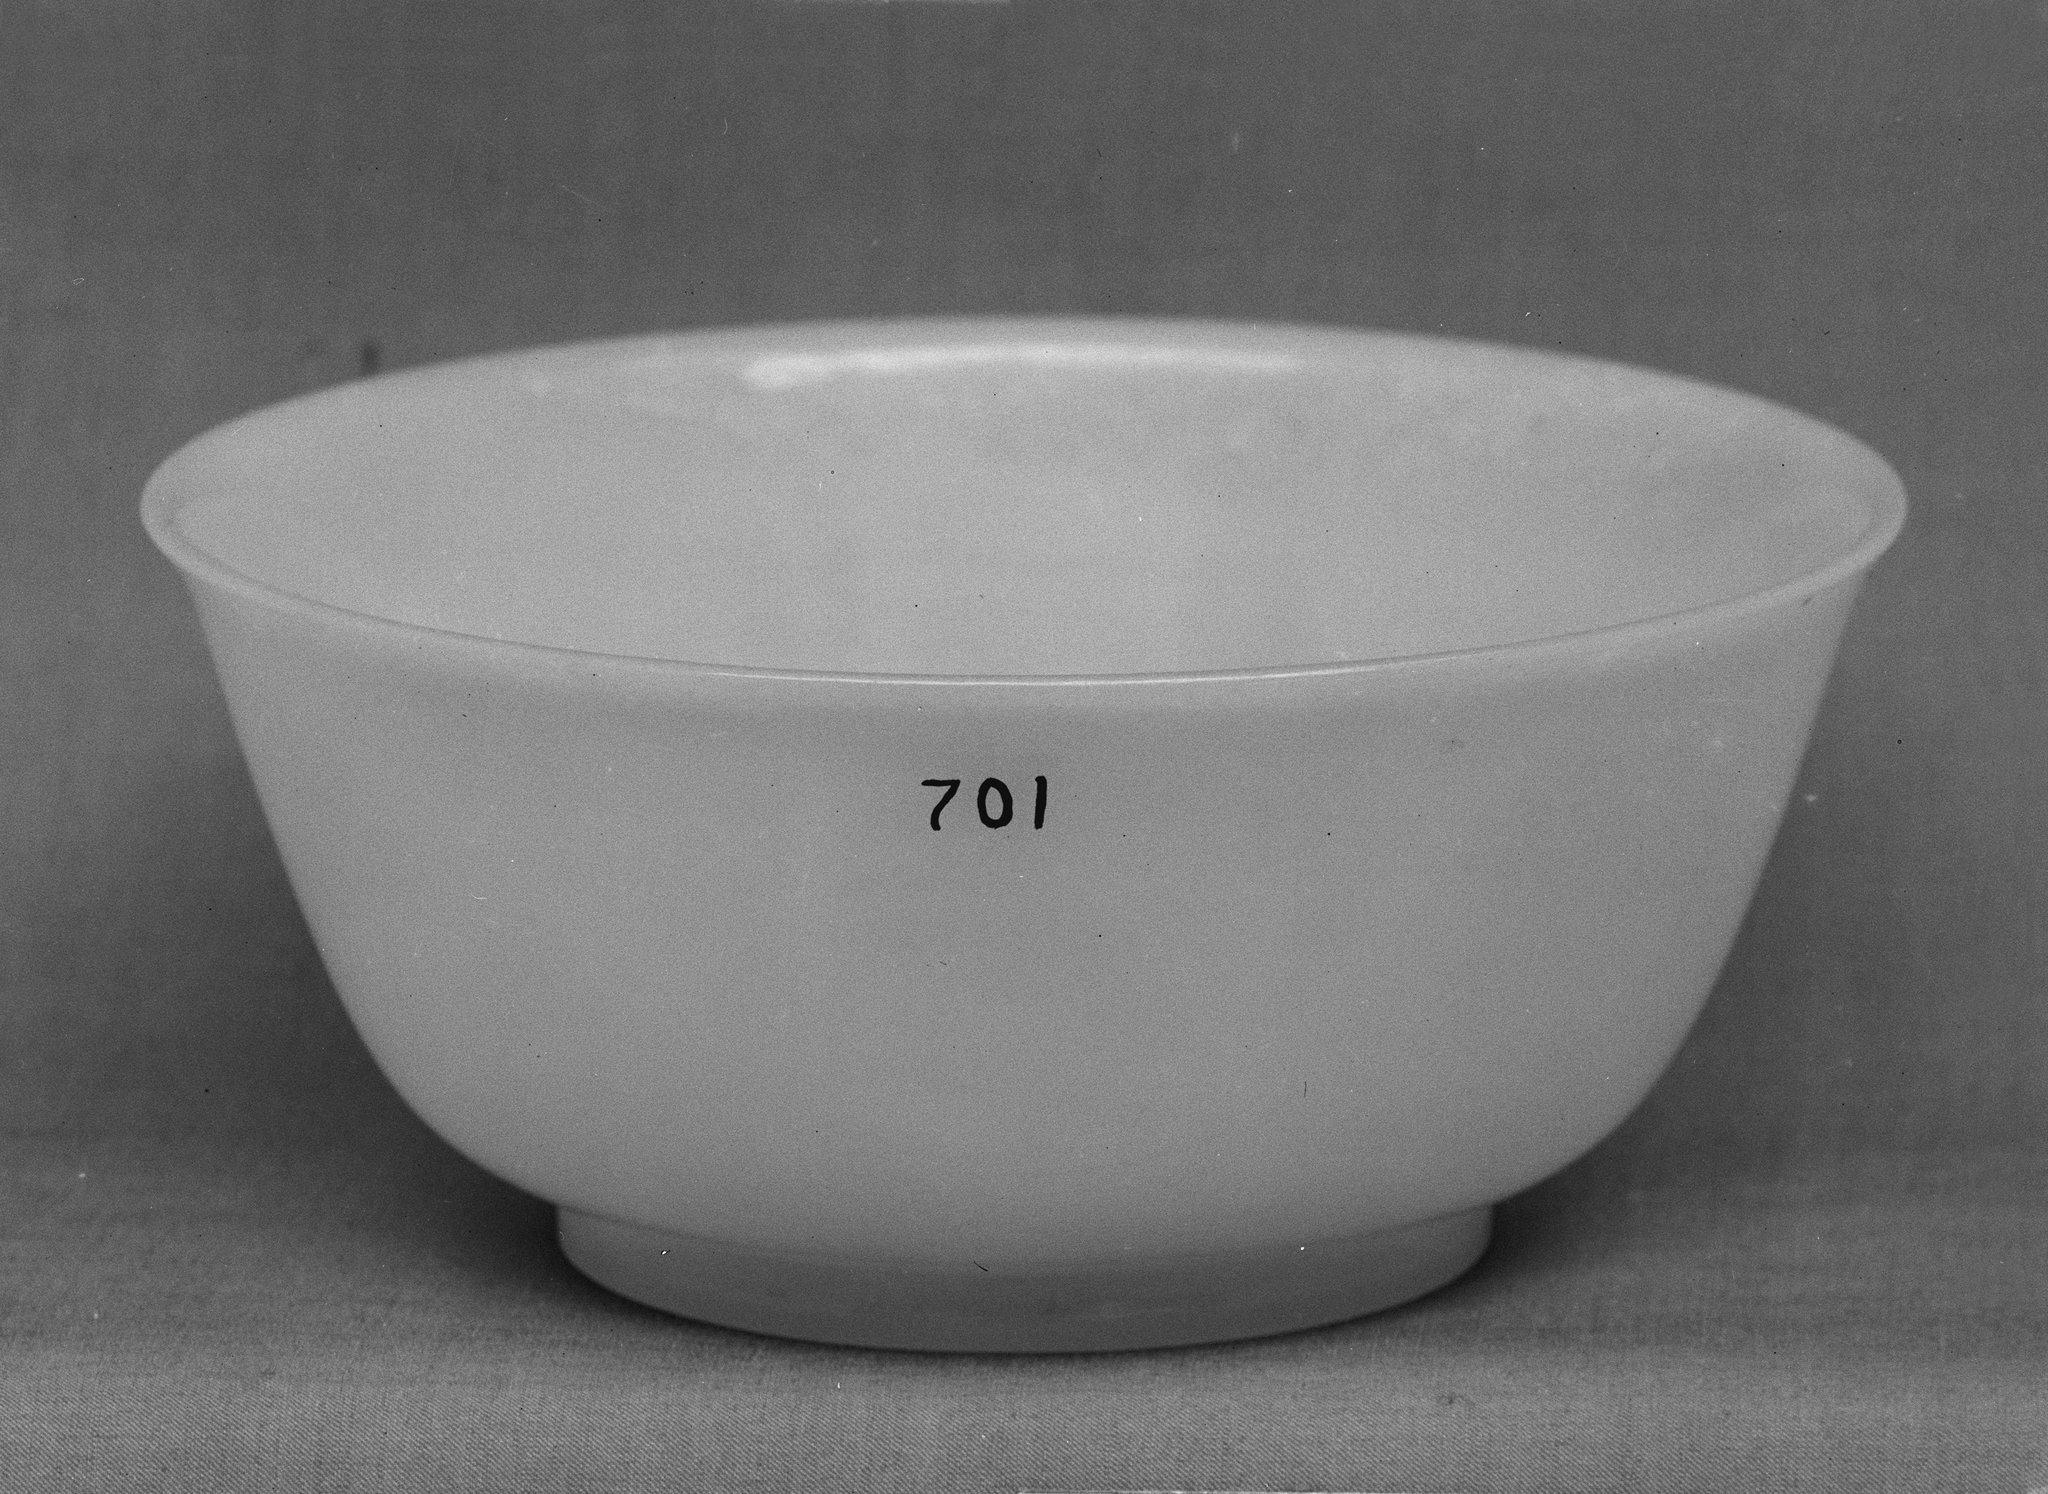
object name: bowl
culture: chinese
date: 1796-1820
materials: jade